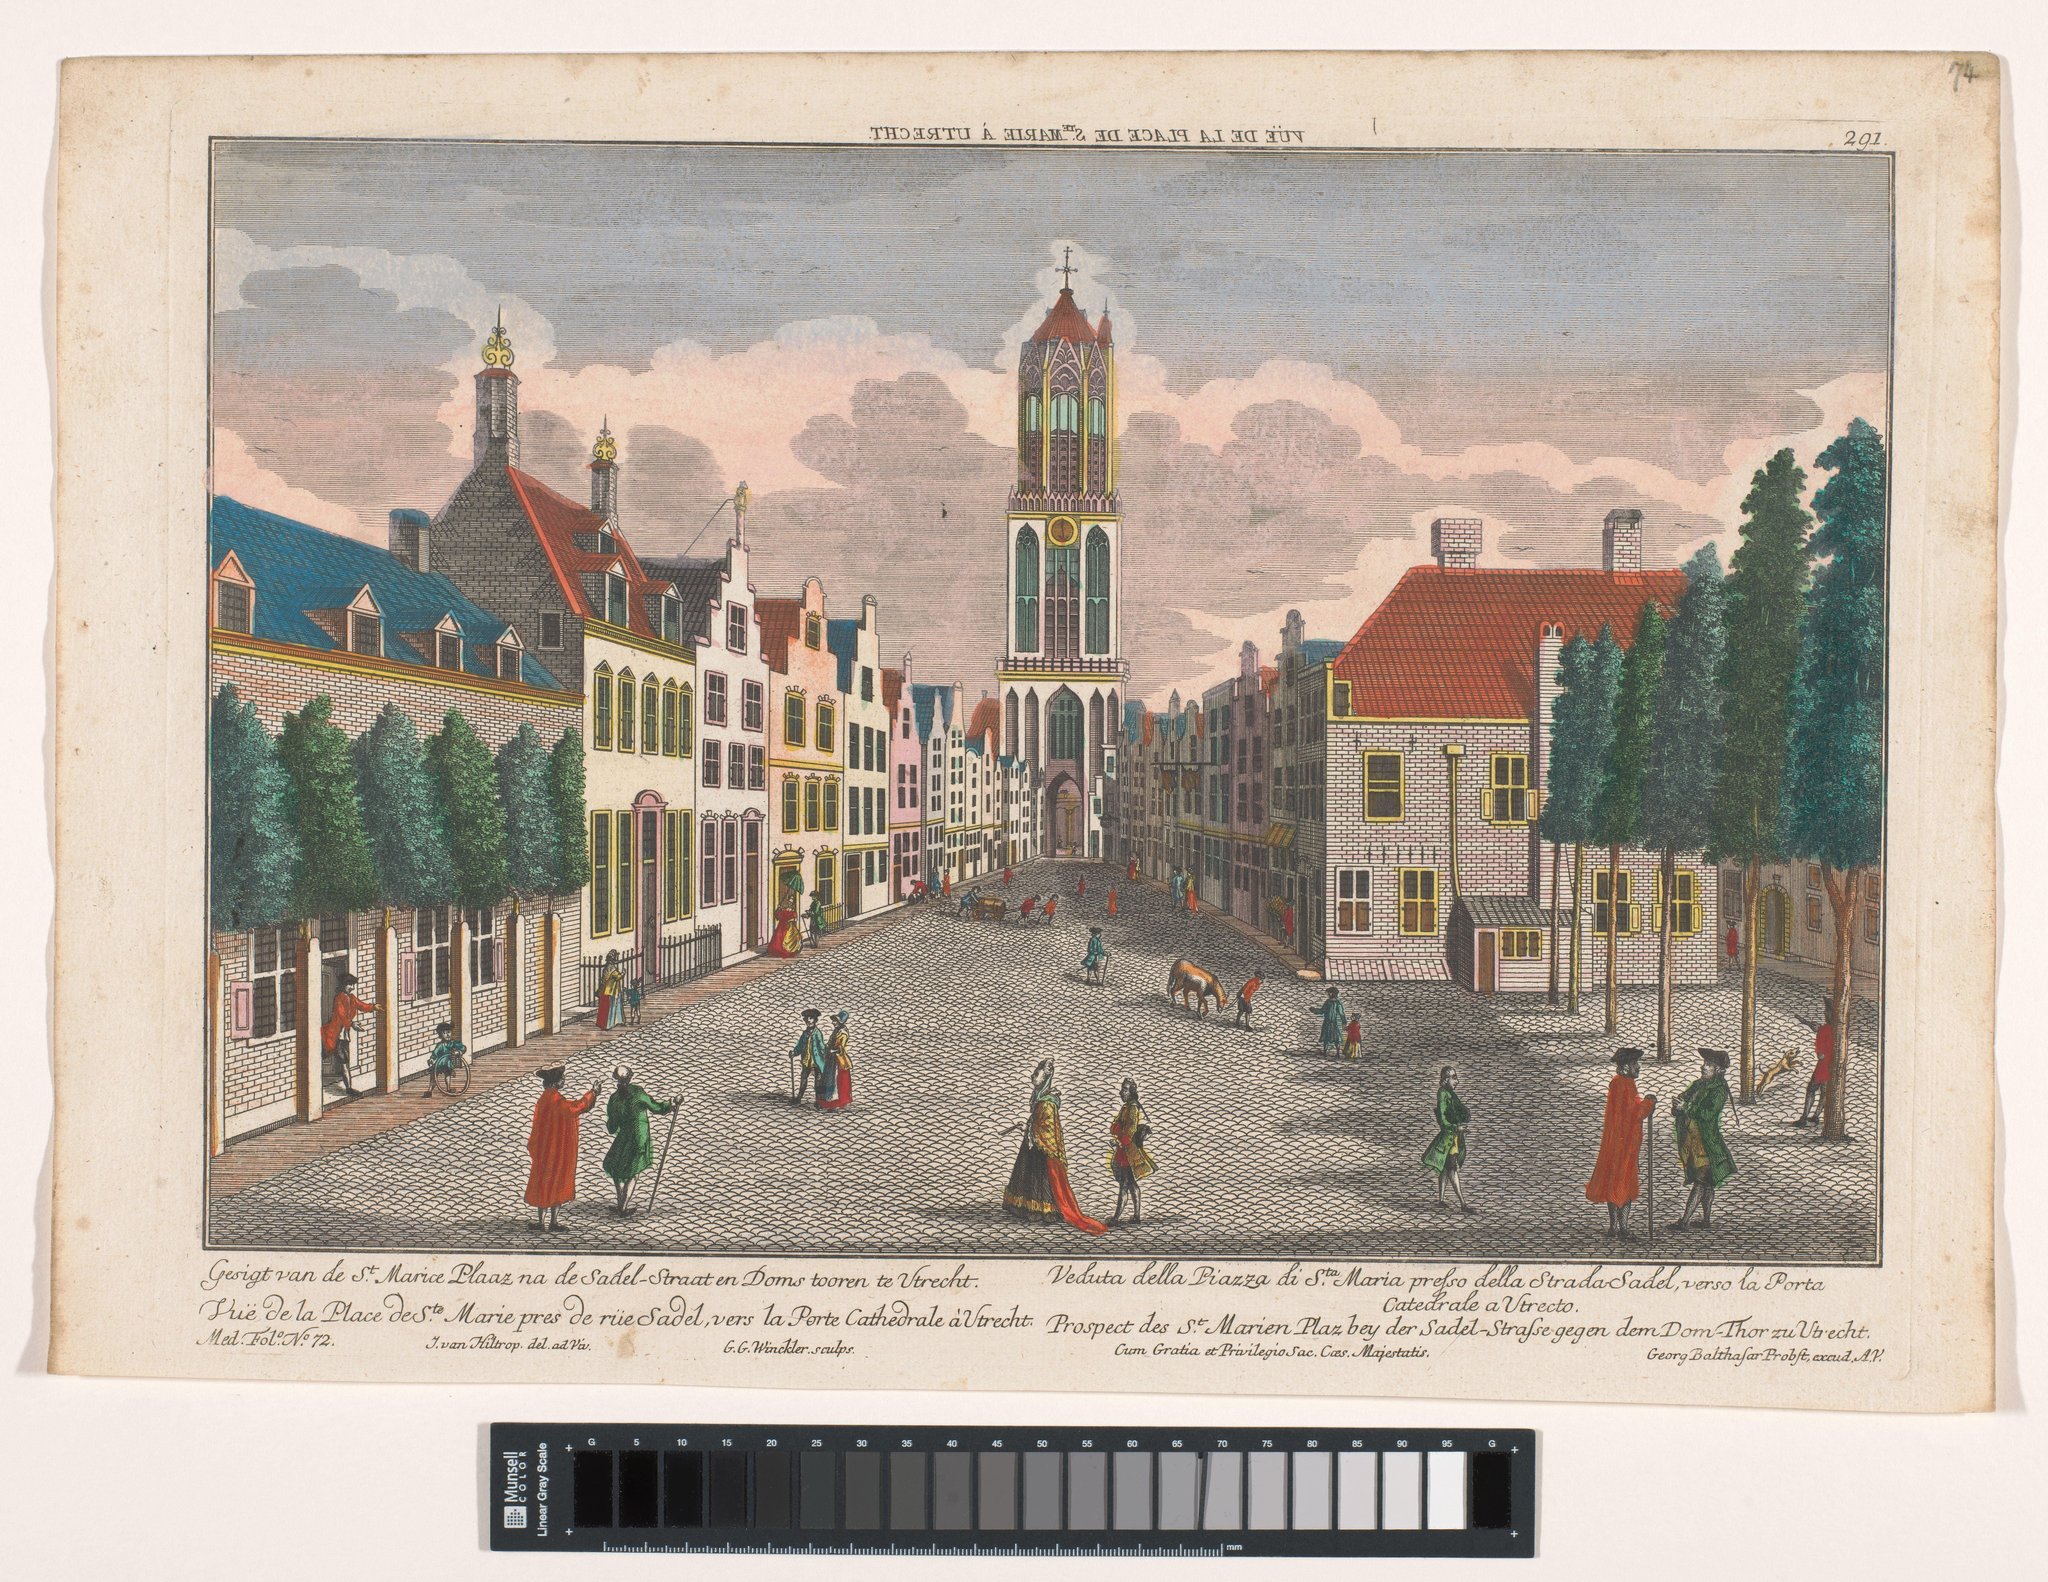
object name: opticaprent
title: Utrecht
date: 1742-1801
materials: paper, watercolor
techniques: brush, etching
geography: augsburg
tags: square, place, circus, etc. (+ city(-scape) with figures, staffage), street (+ city(-scape) with figures, staffage), parts of church exterior and annexes: tower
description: De serie “Utrecht”, met het nummer 72, bevat vier prenten met de nummers 291-294, waarvan dit nummer 291 is.